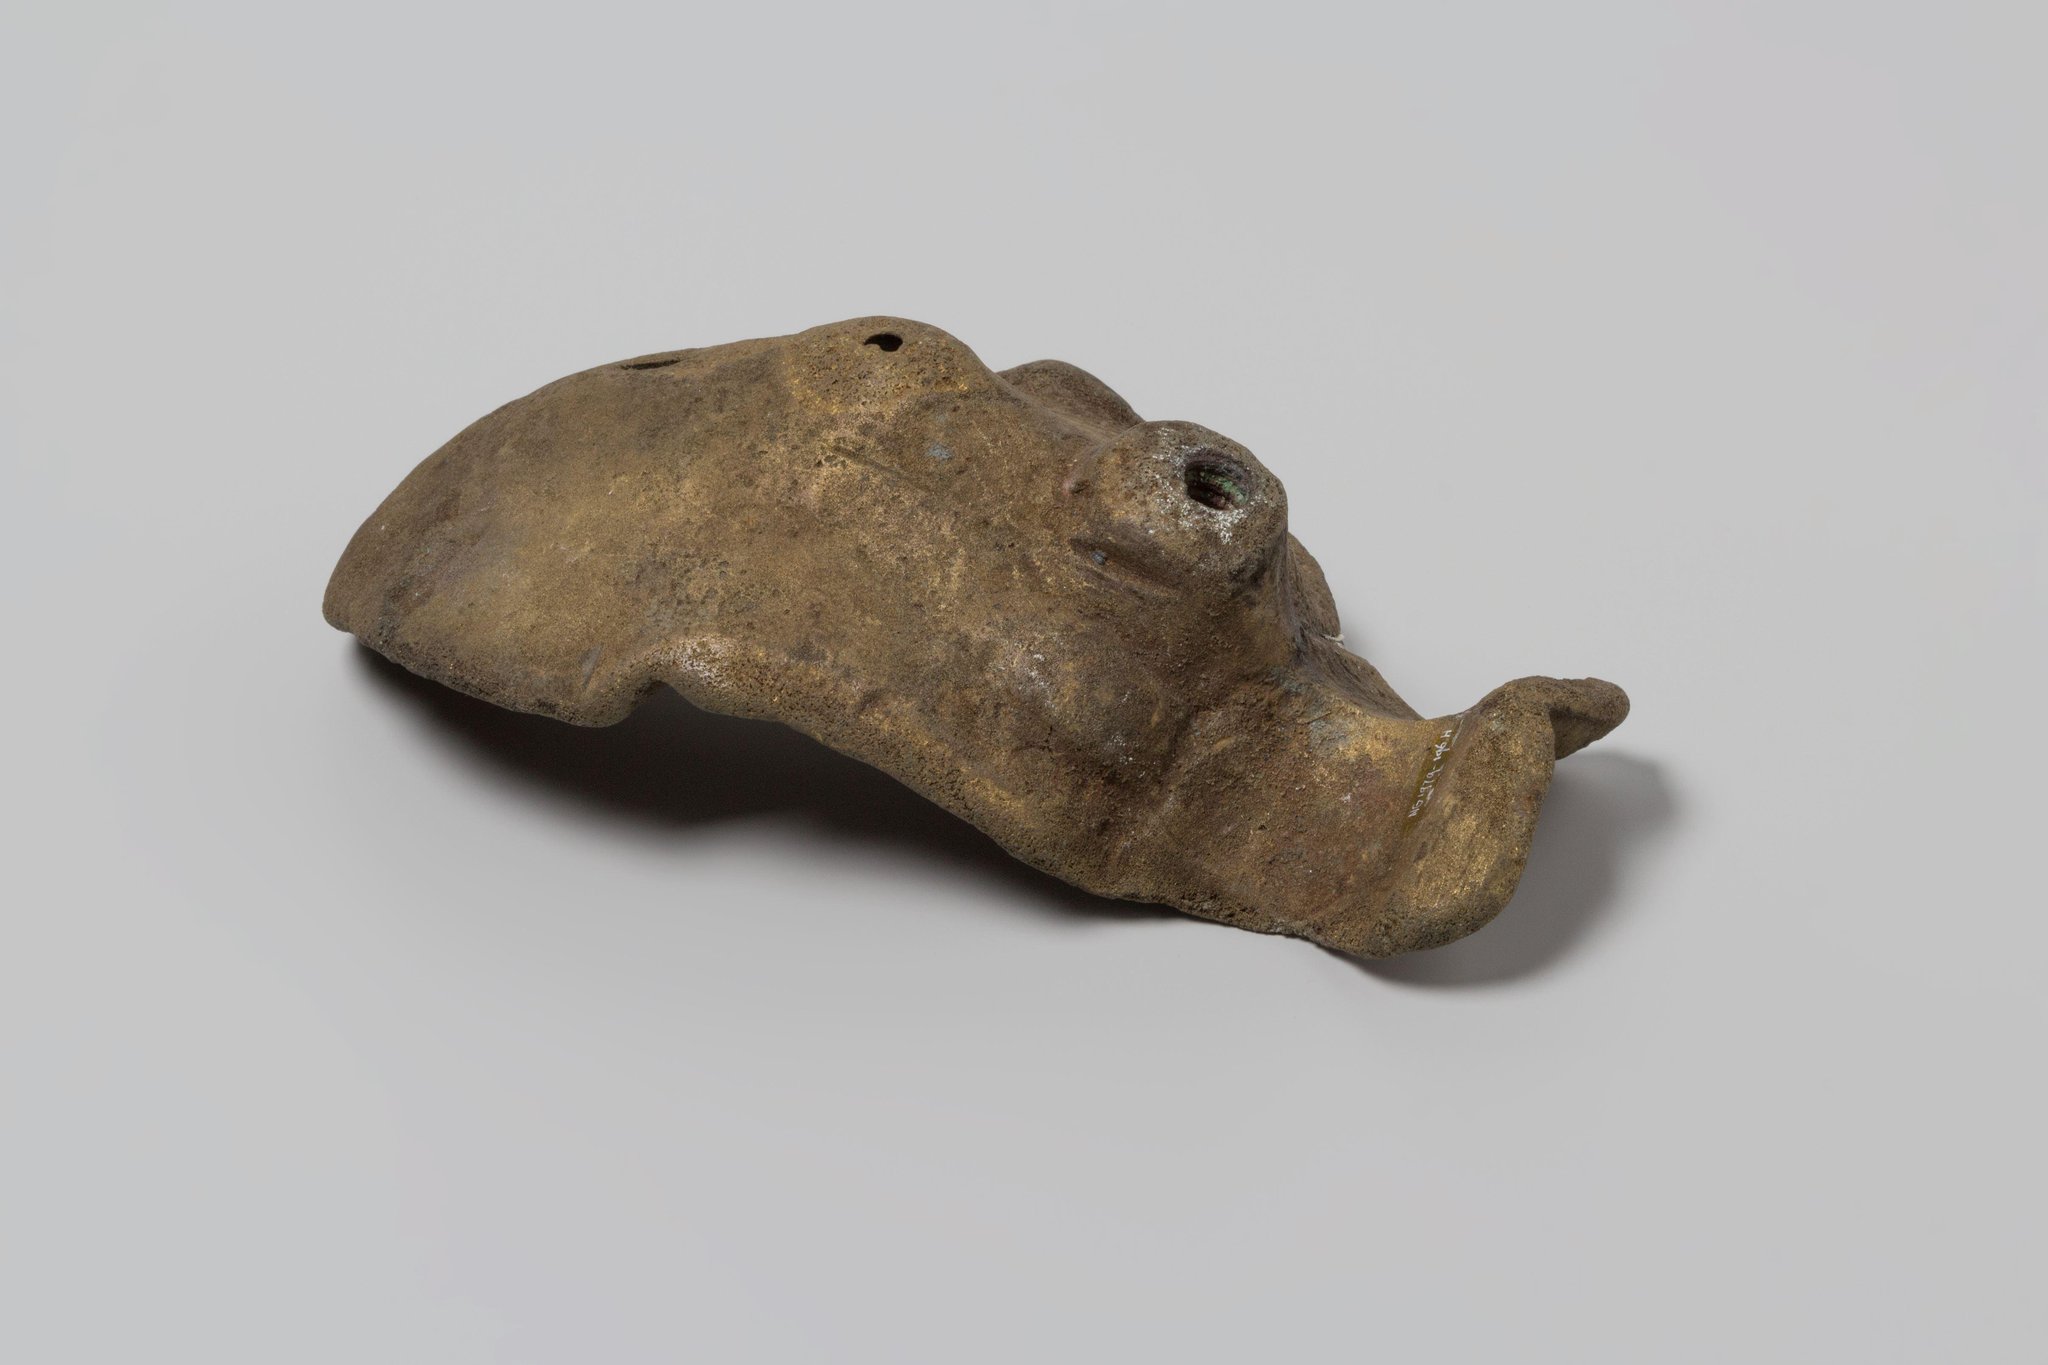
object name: mould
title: Mal uit het wrak van de Oost-Indiëvaarder Hollandia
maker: Anonymous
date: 1700-1743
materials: copper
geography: netherlands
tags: verenigde oostindische compagnie, hollandia (schip), annet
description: Tools and instruments, lead casting, mould; mould: egg-shaped outline, curved, cast design on concave side, single bead with foliate motif, on the reverse handle fitting id. NG 1979-192H3074.